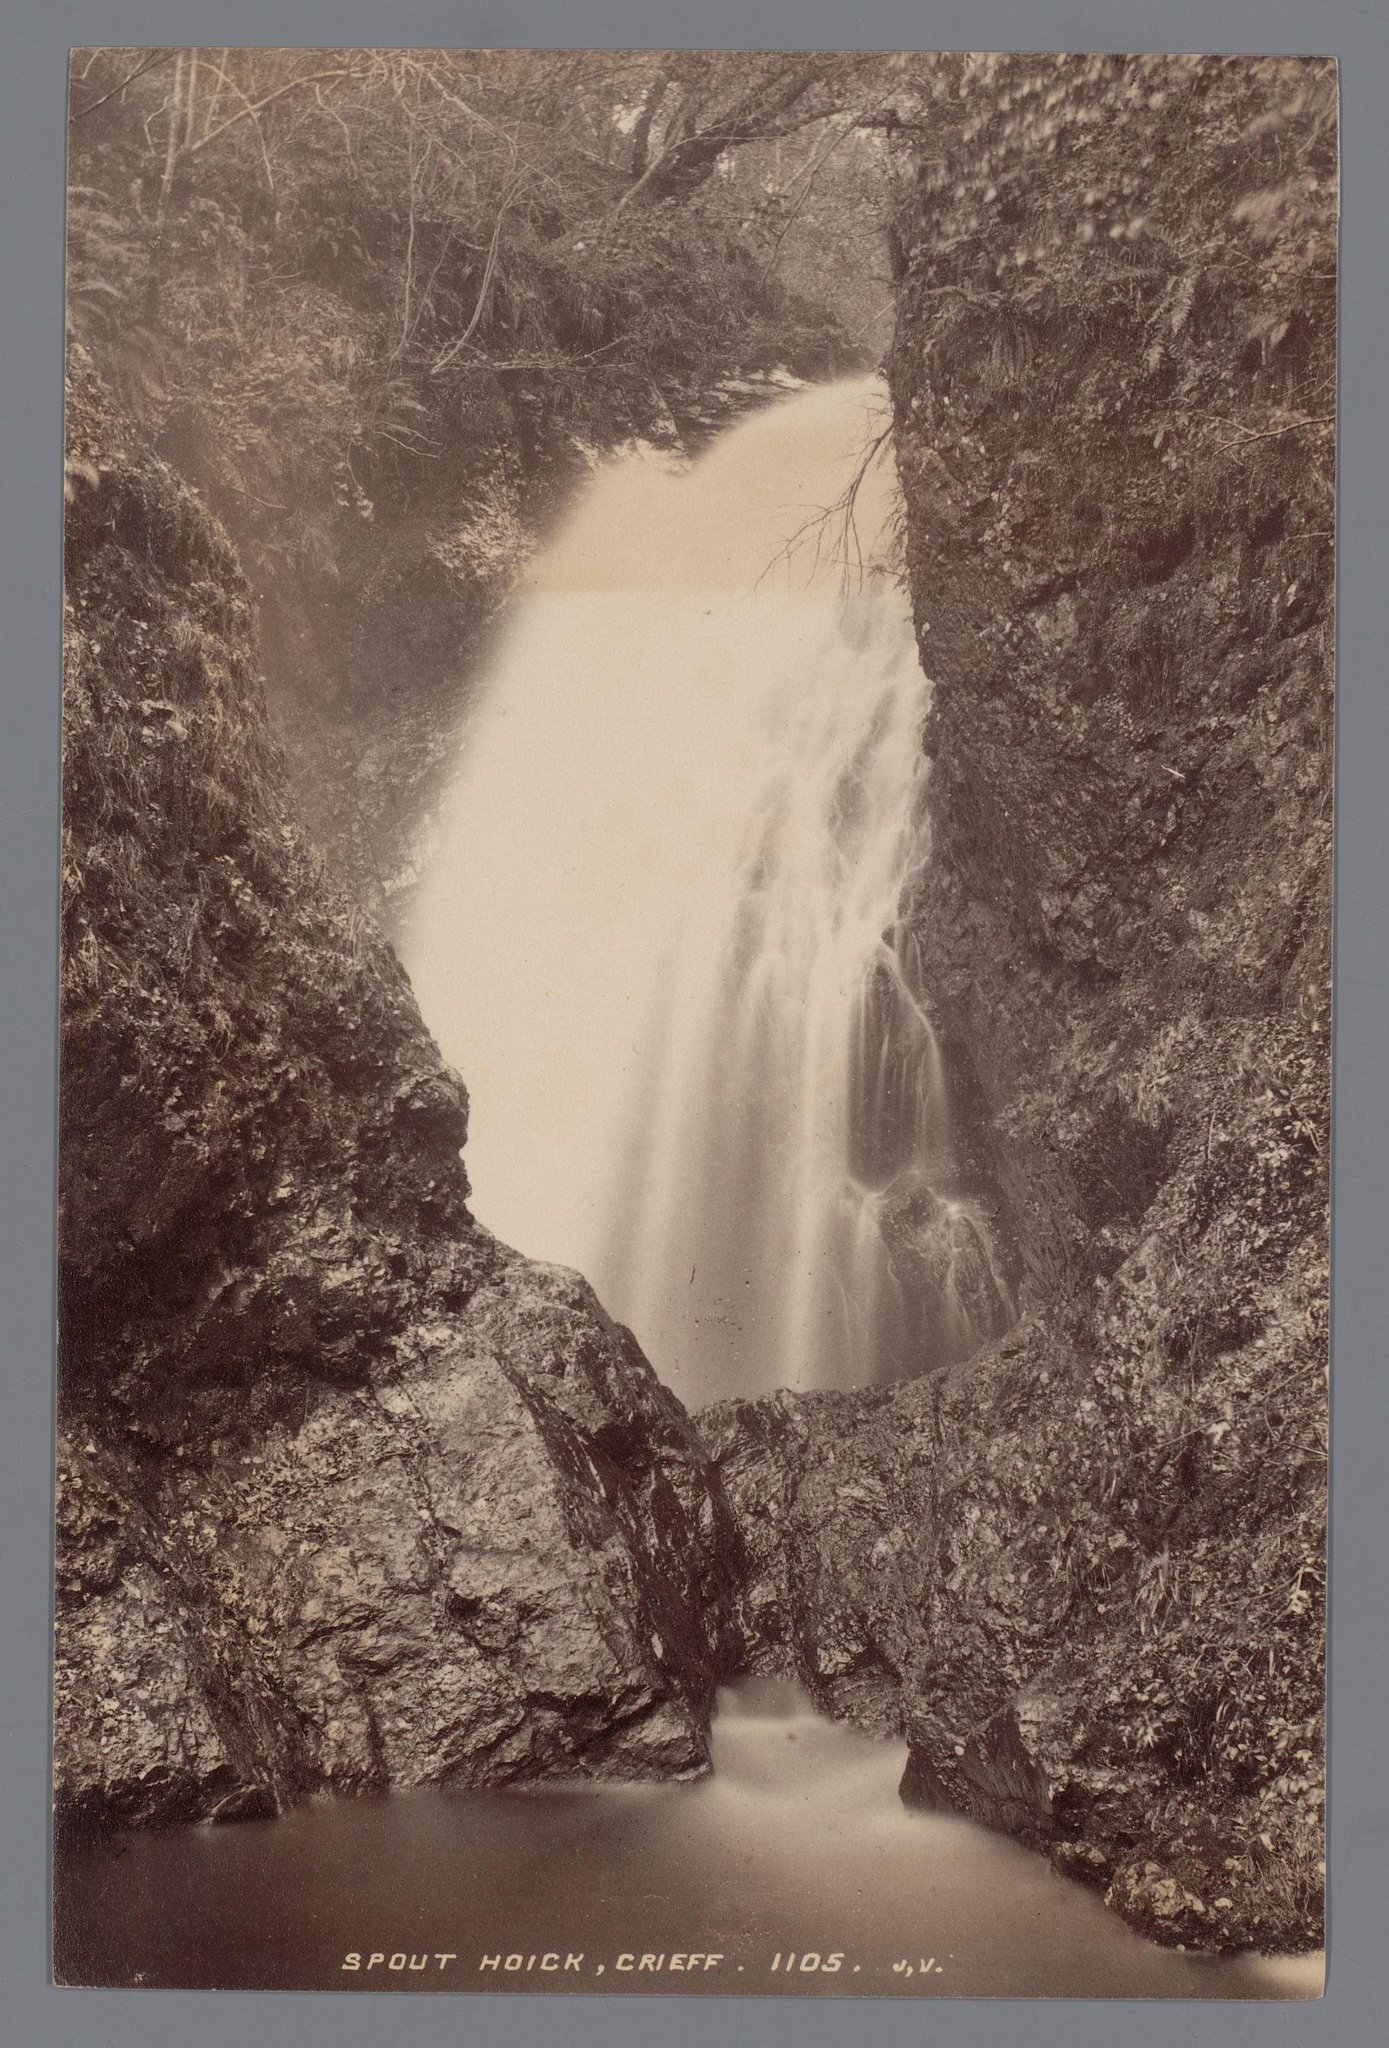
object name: photograph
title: Waterval met rotsen en vegetatie (Spout Hoick in Crieff, Schotland)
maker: james valentine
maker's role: fotograaf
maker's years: 1815-1880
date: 1860-1880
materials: photographic support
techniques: albumen print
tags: crieff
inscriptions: inscription: ‘J, V.’, inscription: ‘SPOUT HOICK, CRIEFF. 1105.’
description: Spout Hoick in de stad Crieff, Schotland. Waterval met rotsen en vegetatie.